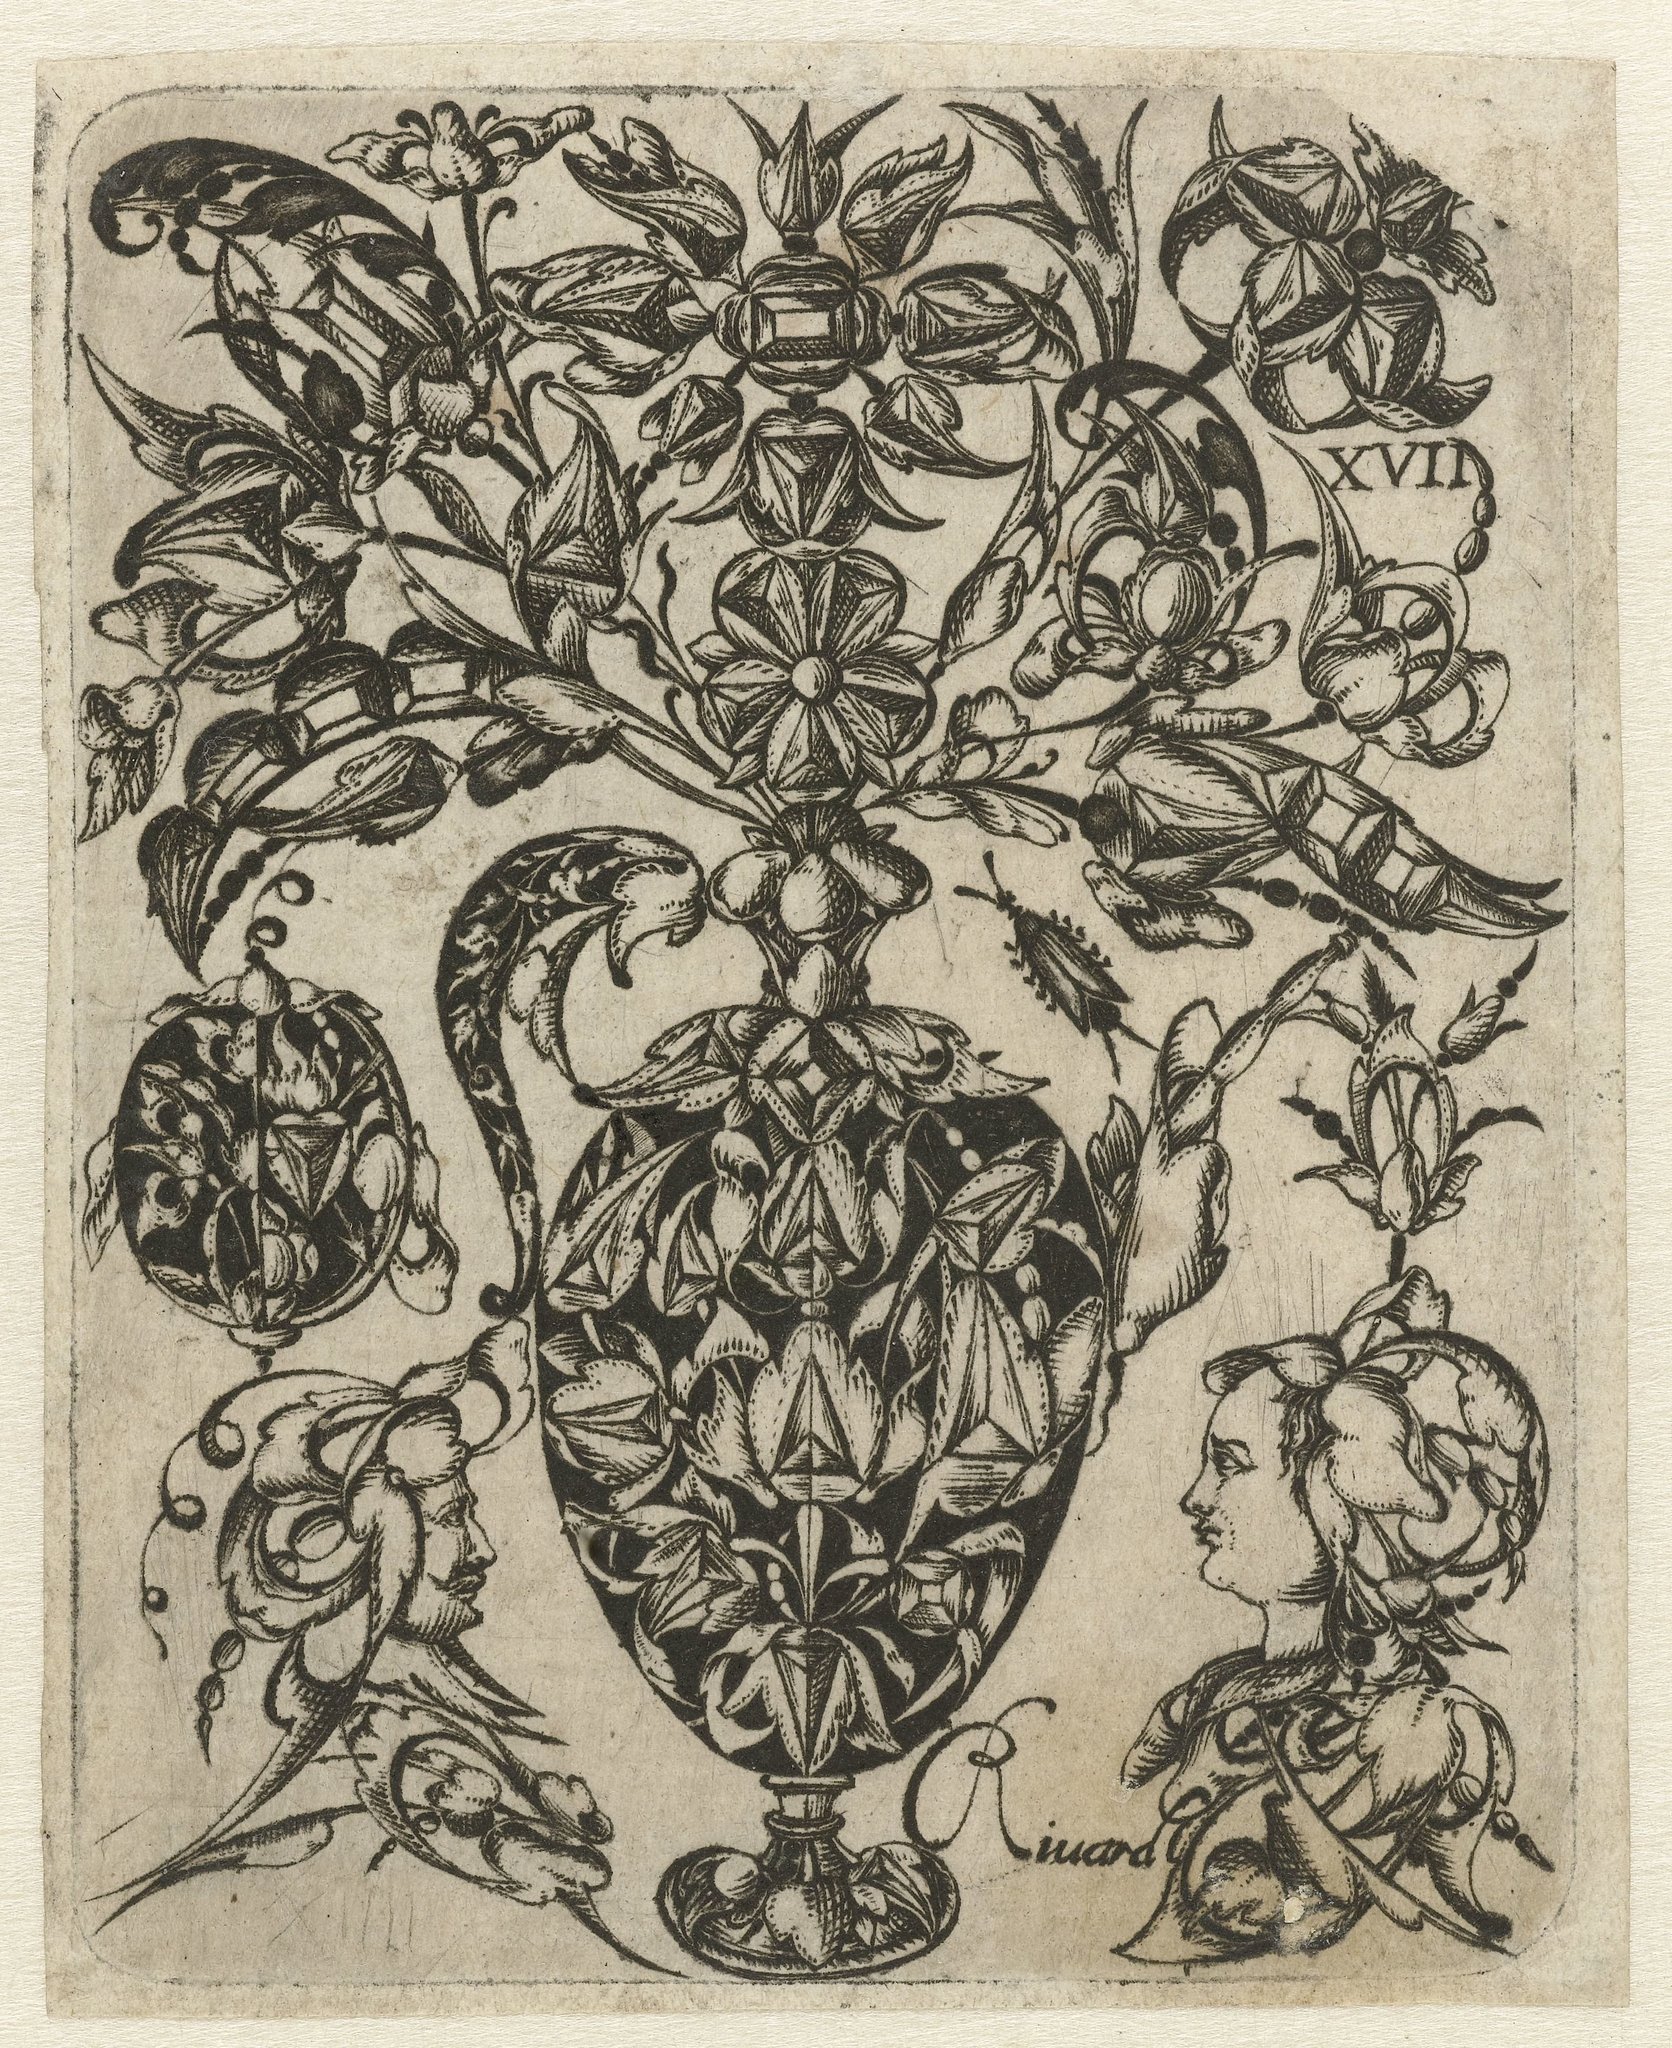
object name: print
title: Bloemornament met vaas en menselijke hoofden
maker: claude rivard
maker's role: print maker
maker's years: 1592-1670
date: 1602-1670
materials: paper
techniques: engraving, etching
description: Fuhring, P. & Bimbenet-Privat, M., 'Le style "cosses de pois" : l'orfèvrerie et la gravure à Paris sous Louis XIII', nr. 427, "non retrouvée"